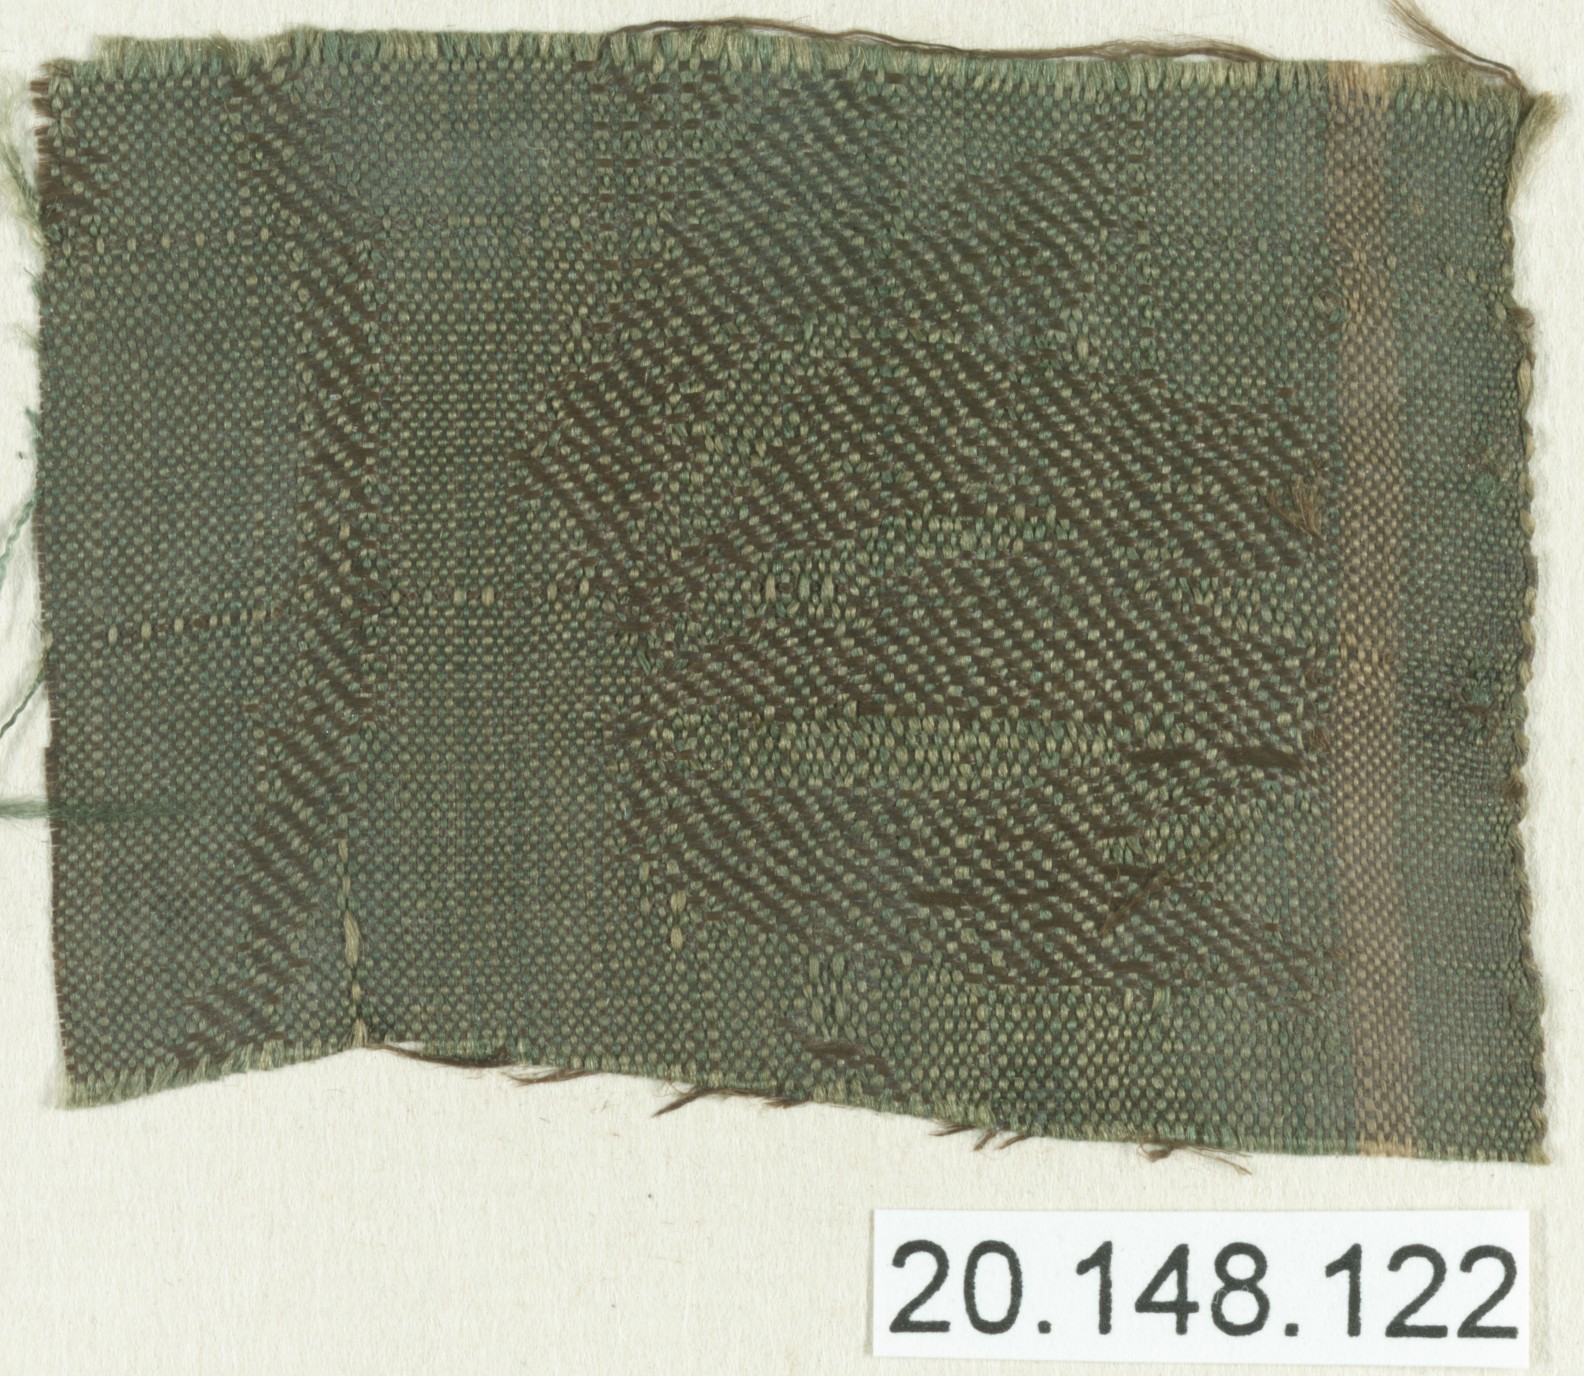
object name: piece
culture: japanese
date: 1601-1700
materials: silk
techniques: compound weave